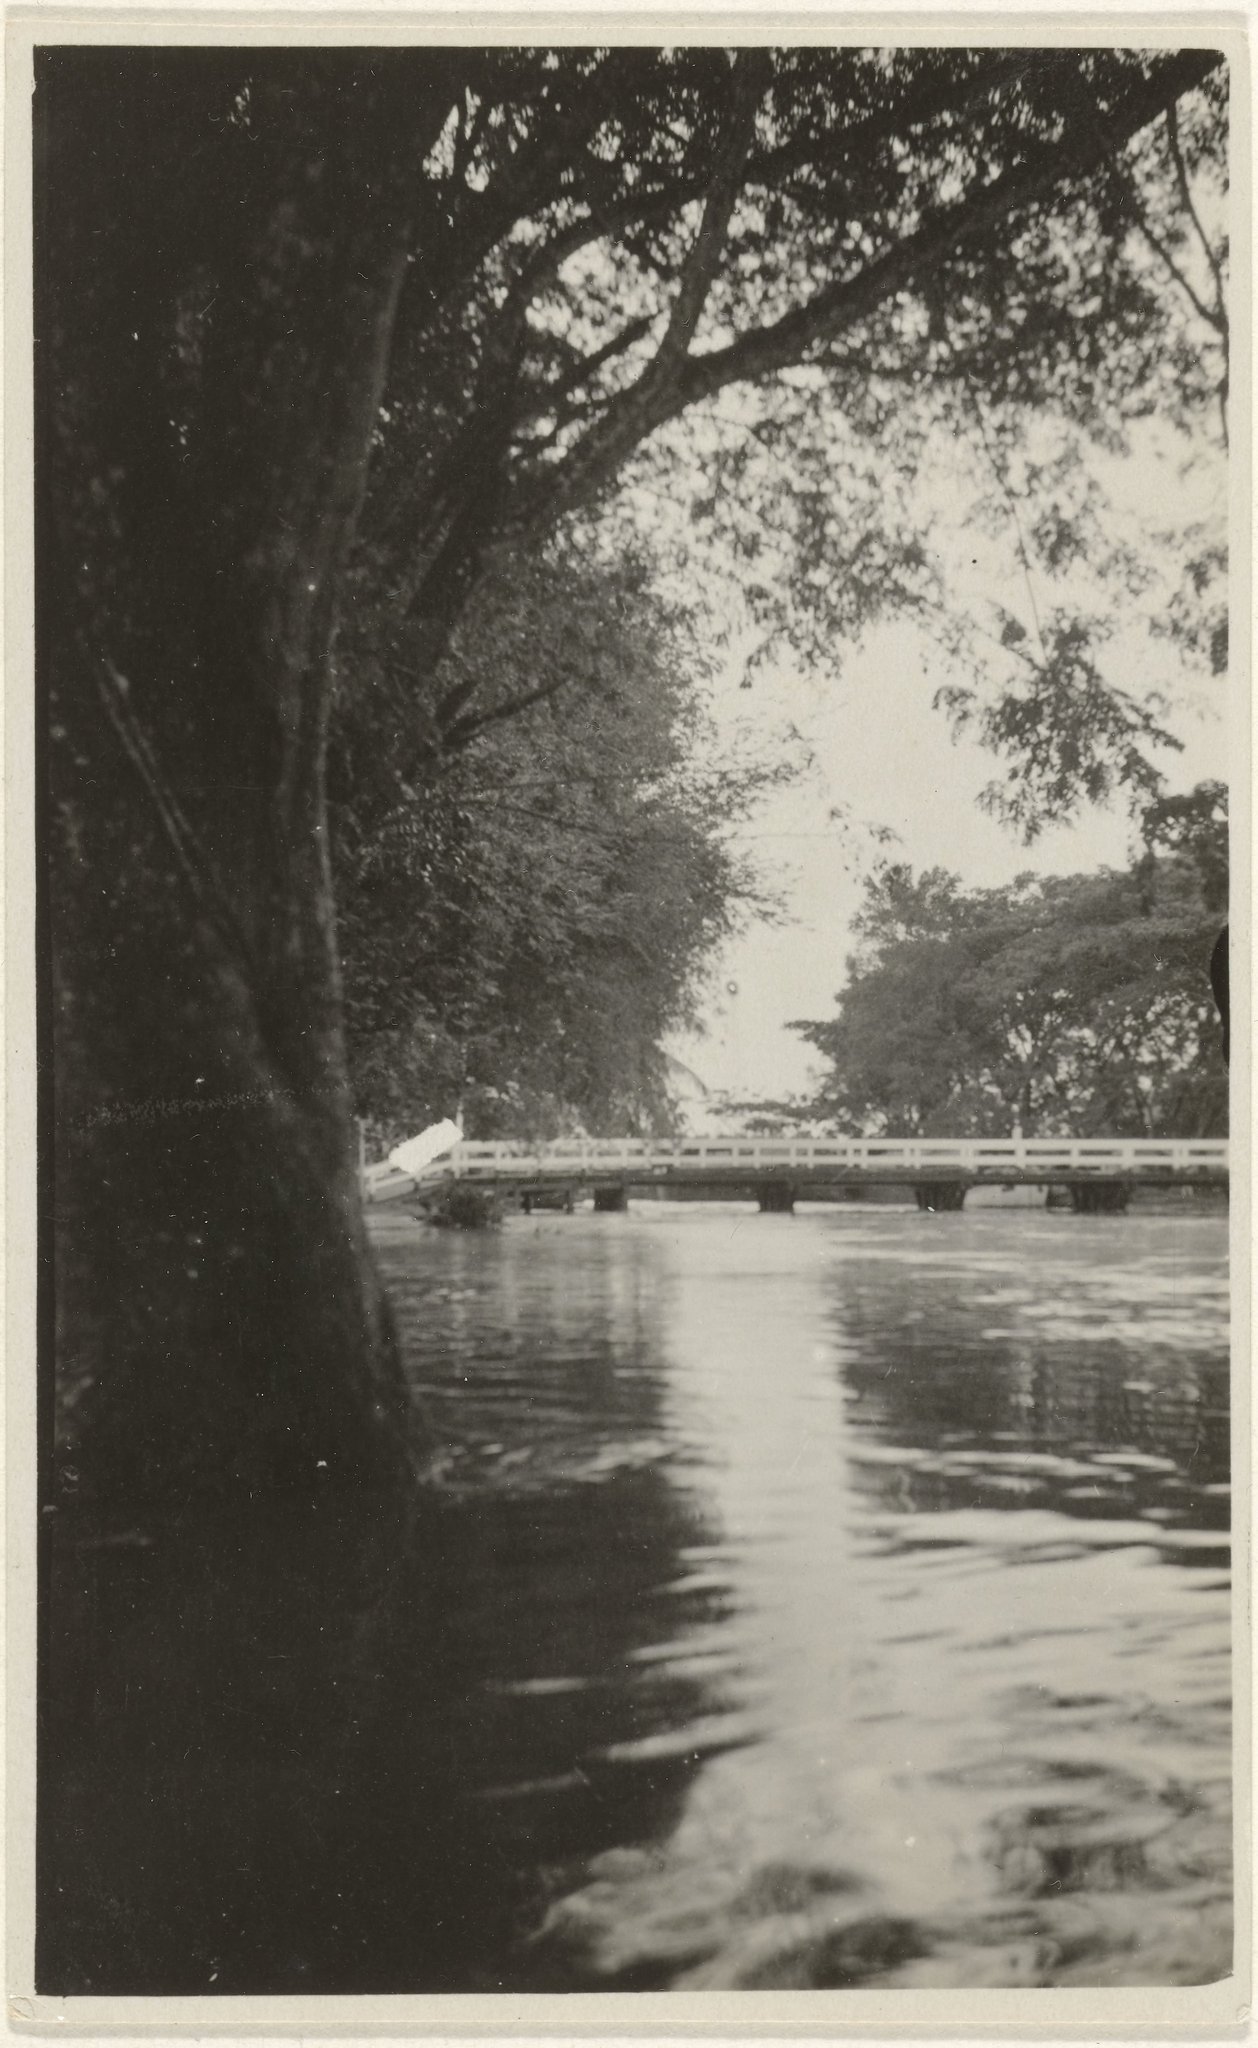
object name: photograph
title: Rivier treedt buiten de oevers in Singkawang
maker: Anonymous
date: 1920-1940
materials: photographic support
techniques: gelatin silver print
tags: borneo